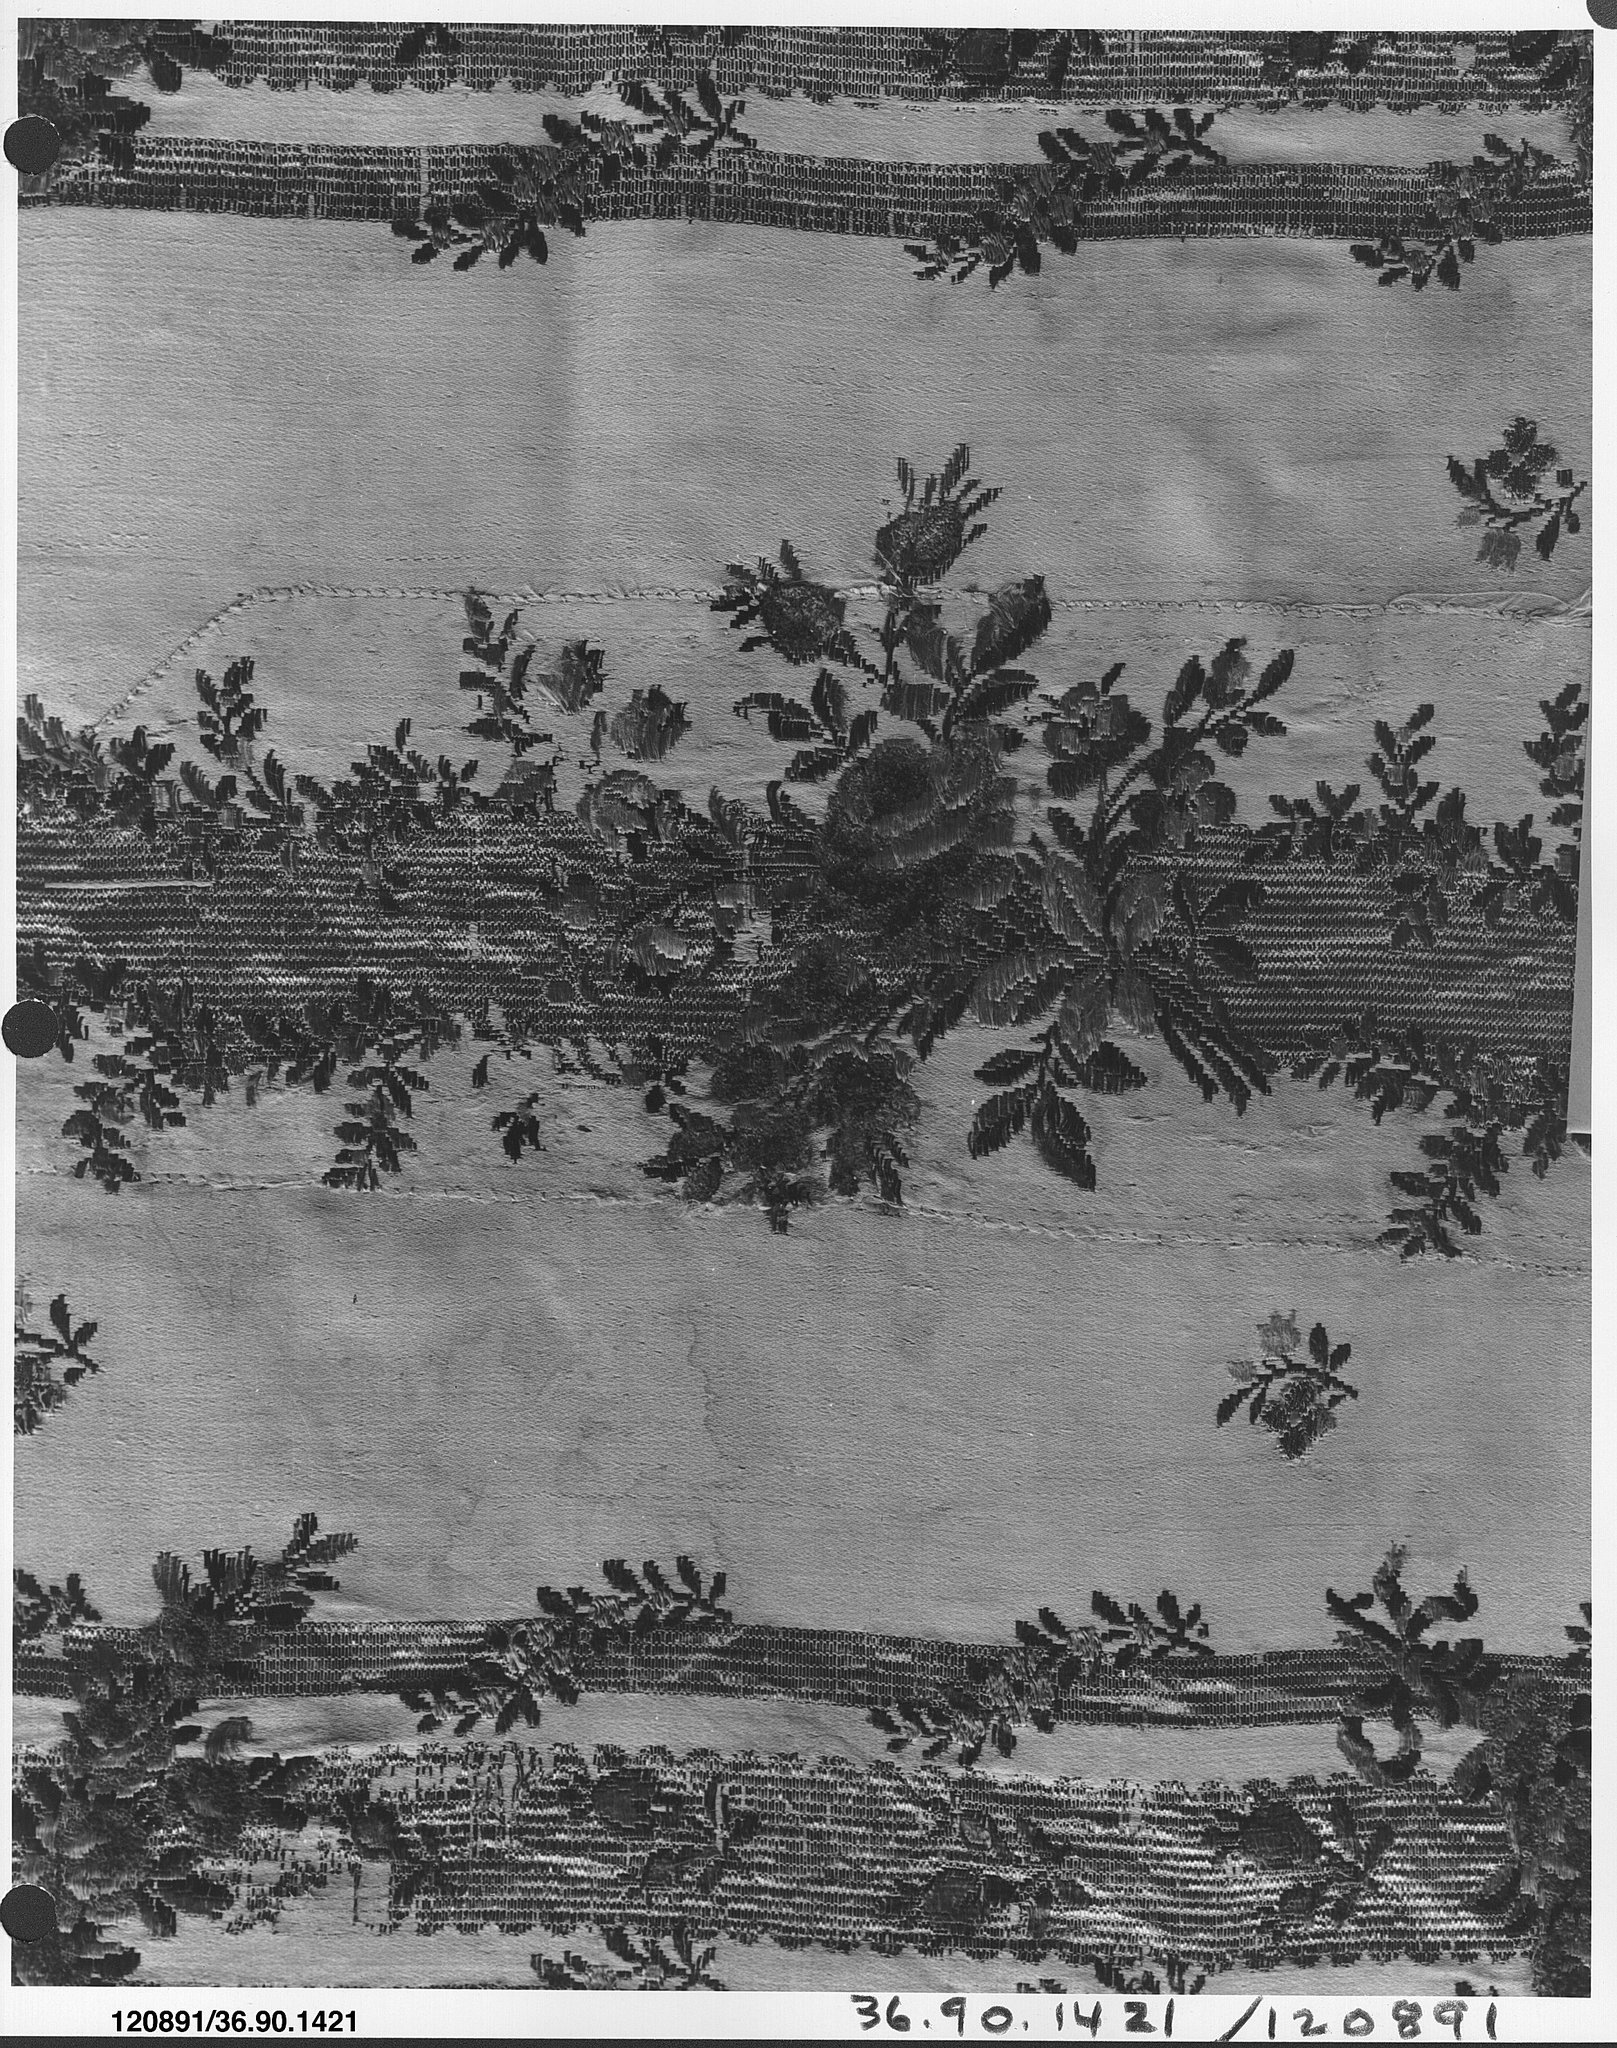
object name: piece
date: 1701-1800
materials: silk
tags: flowers,leaves